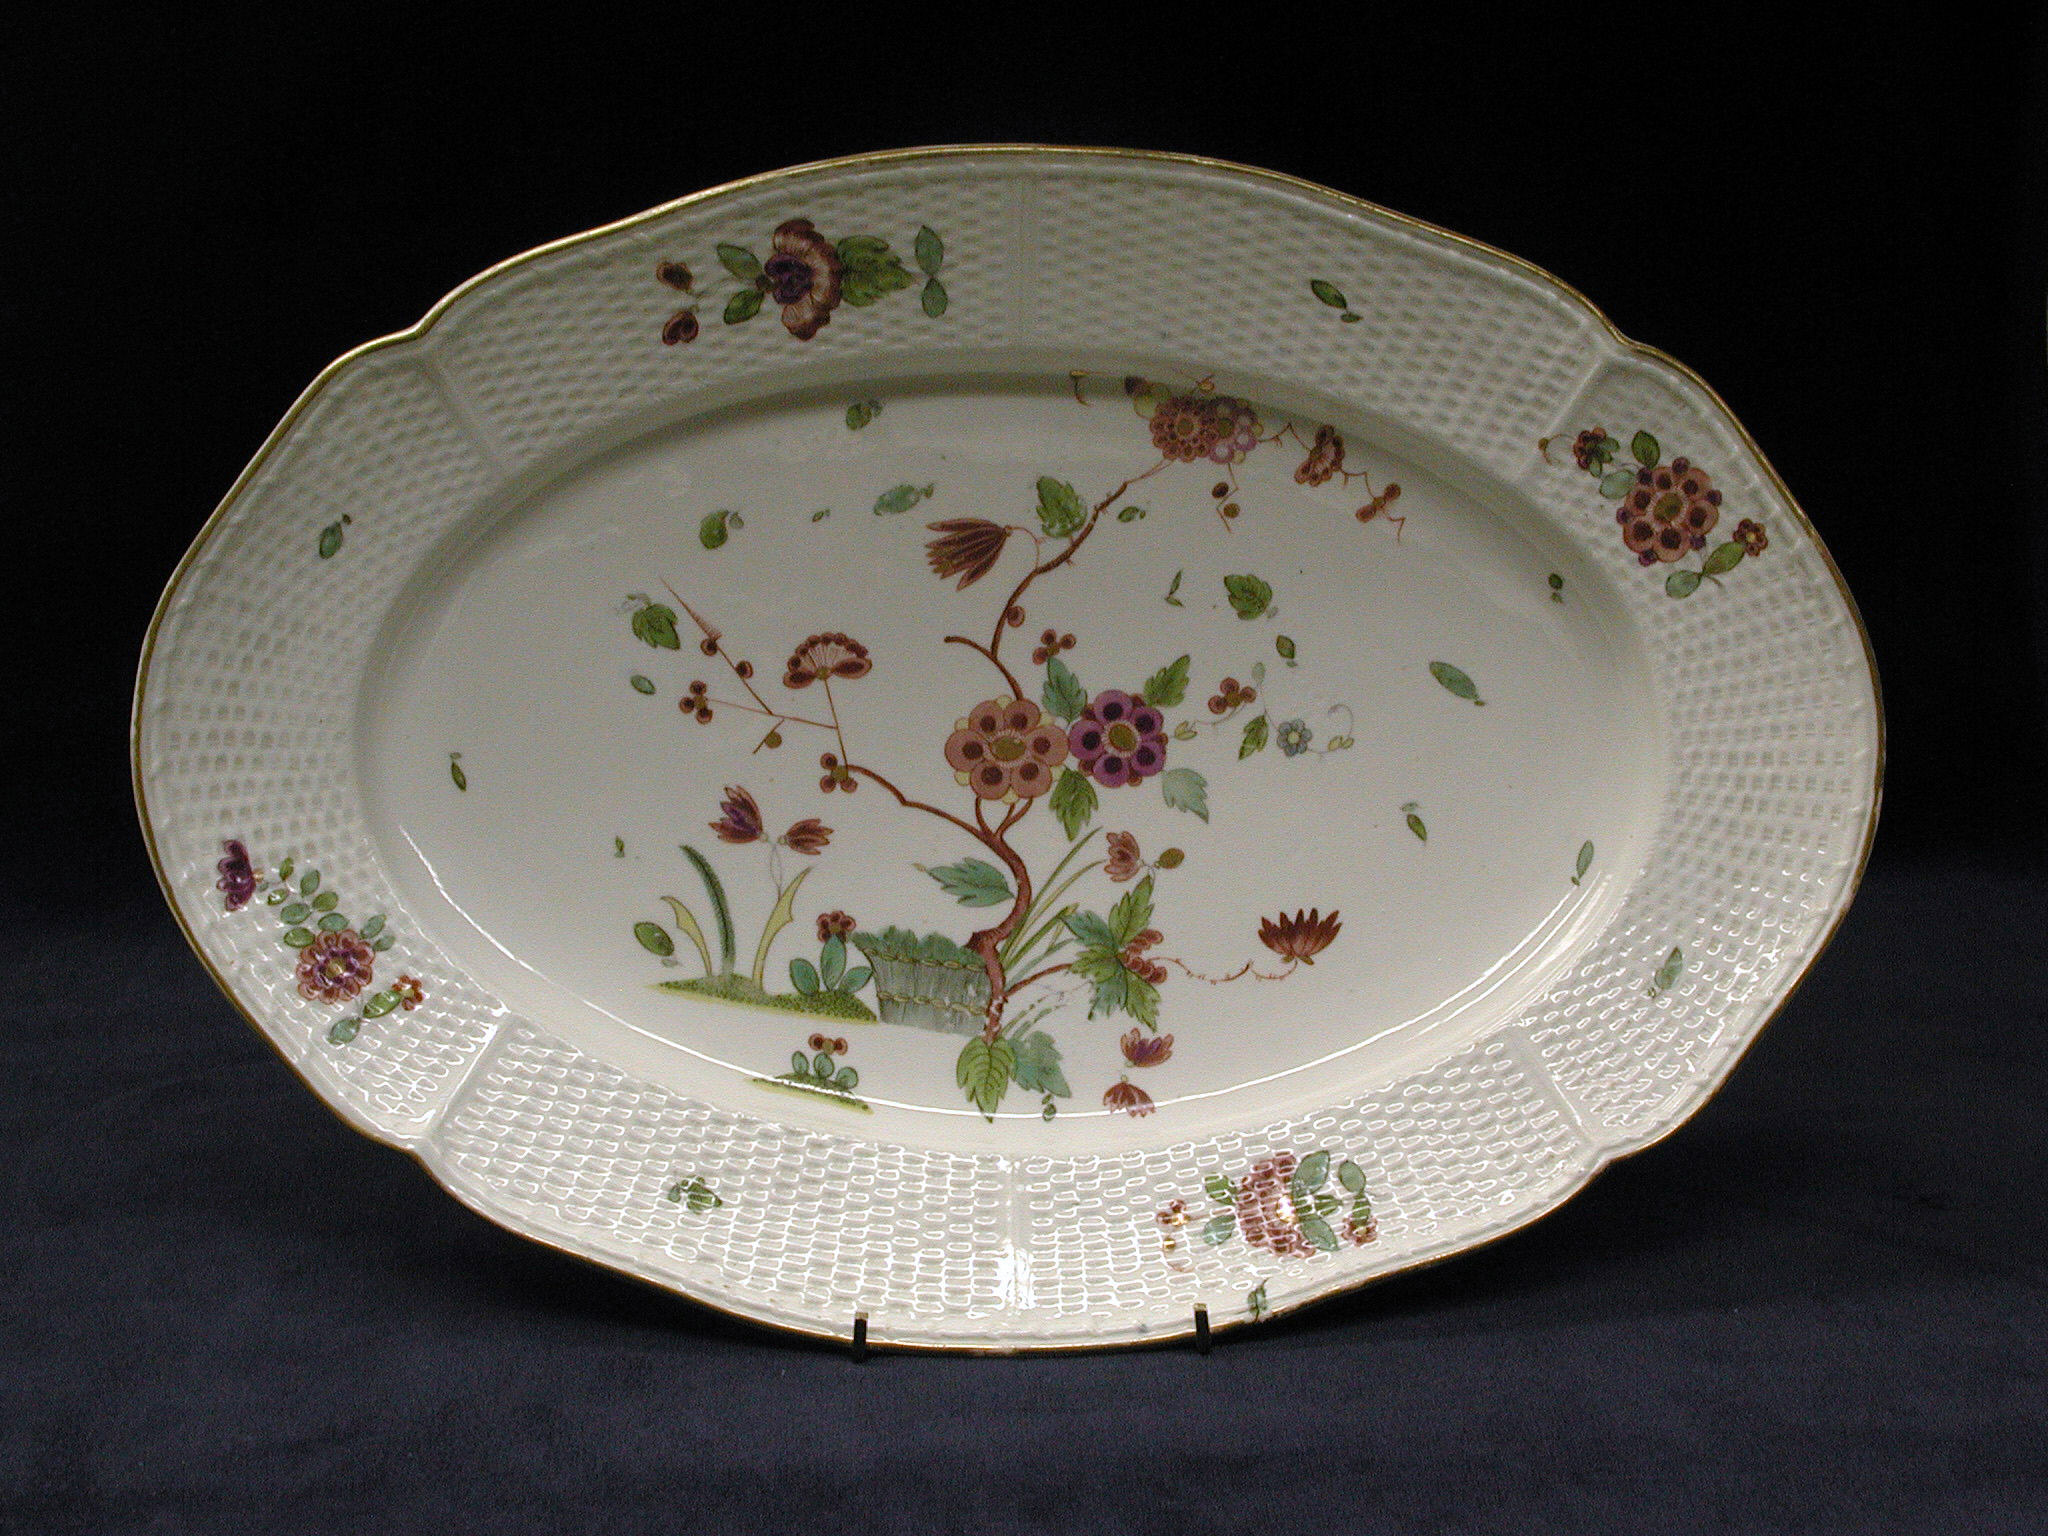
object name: platter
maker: frankenthal porcelain manufactory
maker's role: manufactory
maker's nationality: german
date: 1757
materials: hard paste porcelain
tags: flowers